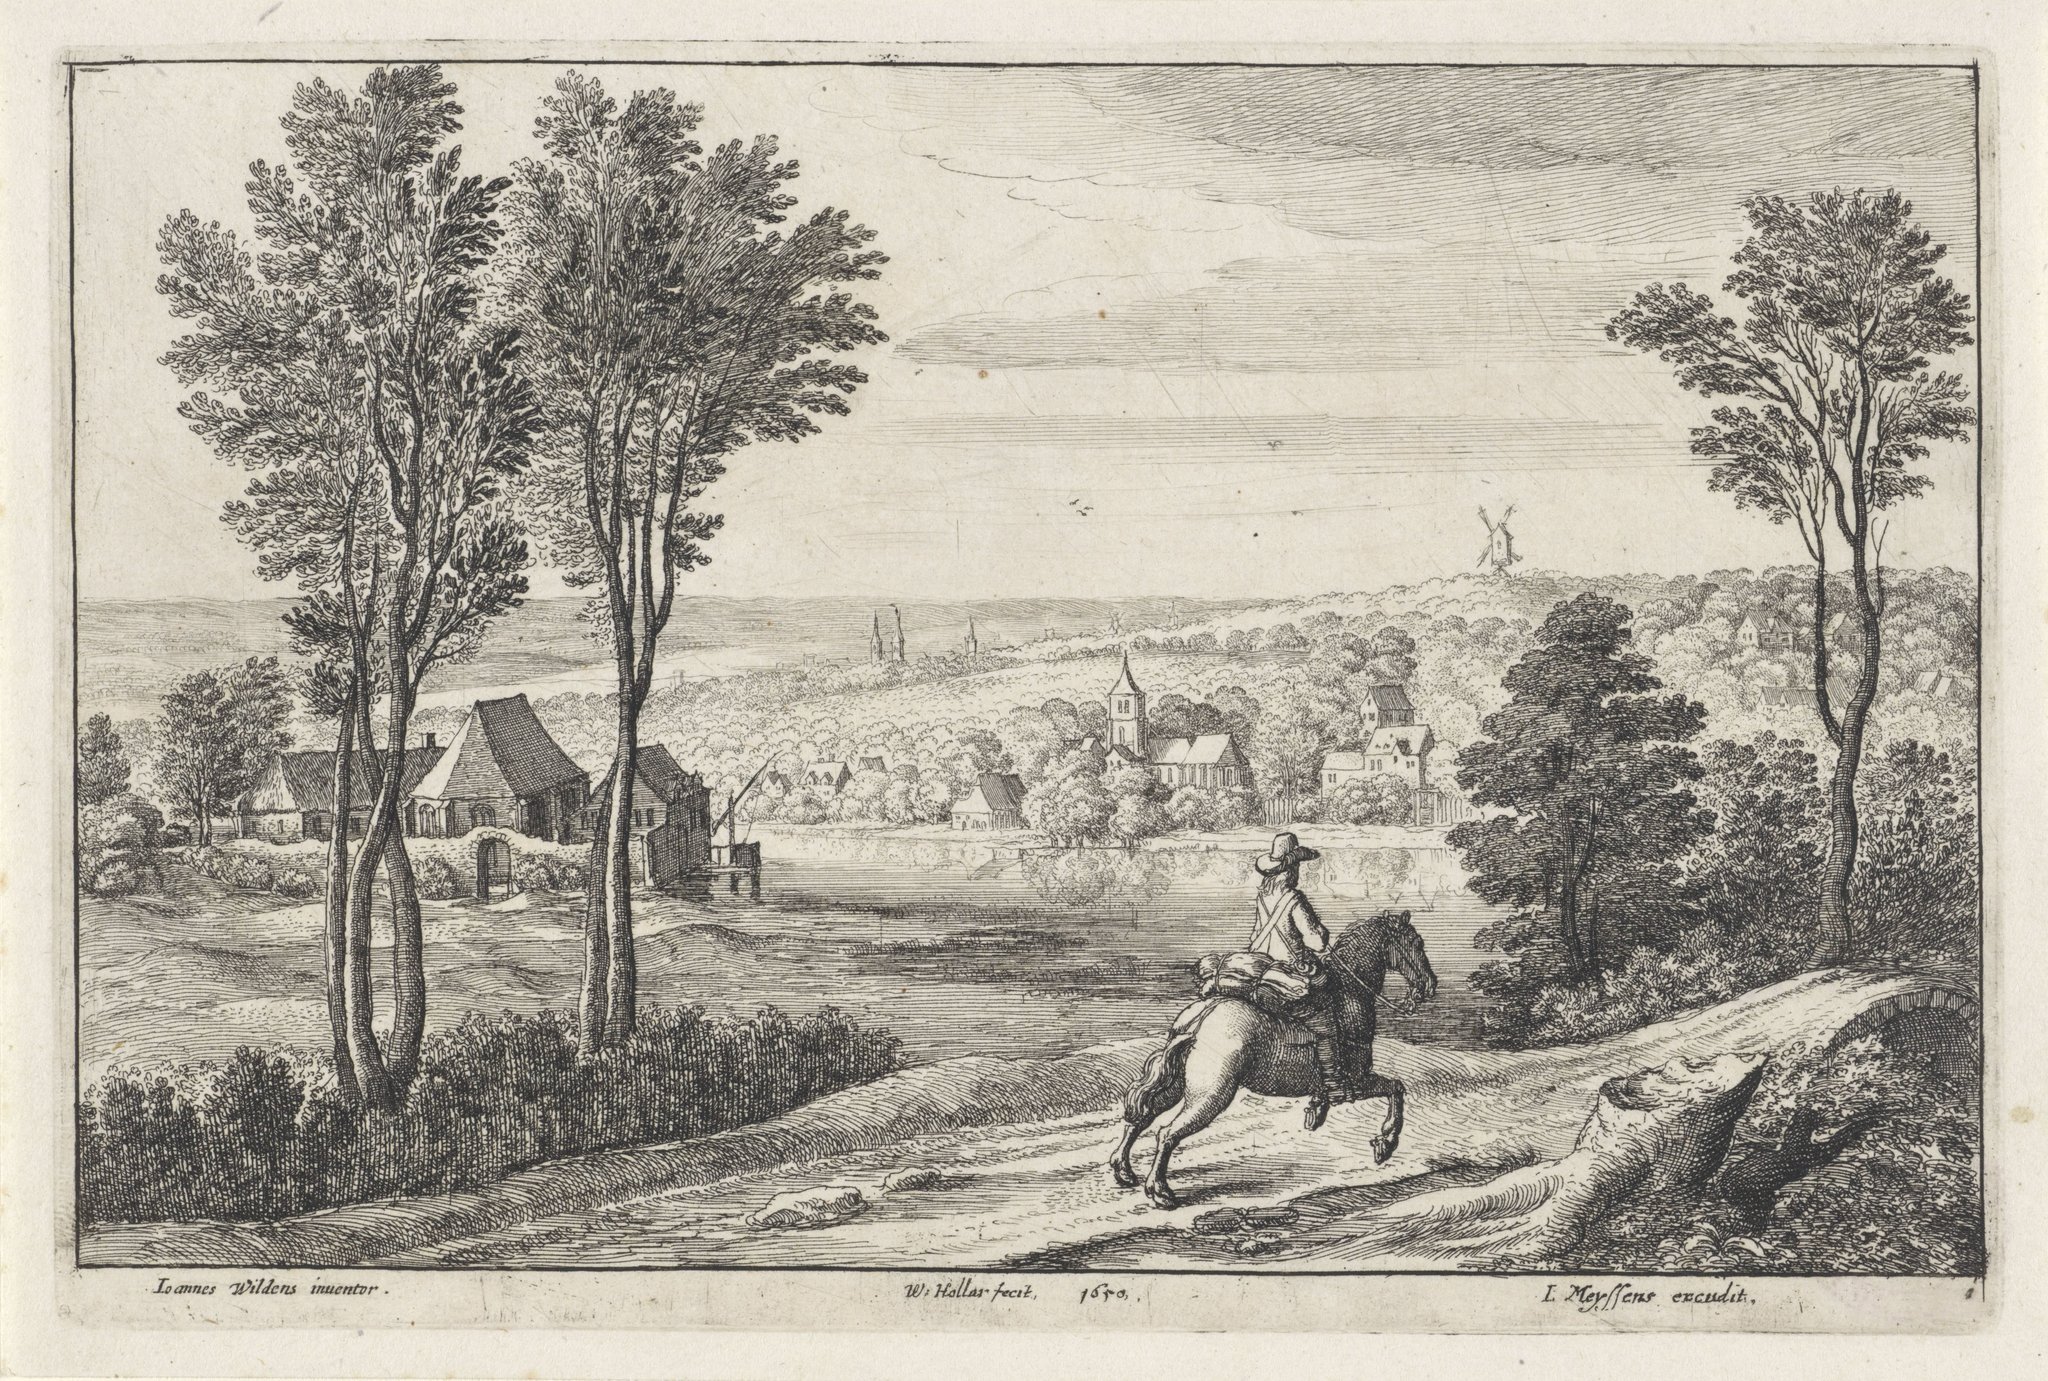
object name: print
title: Landschappen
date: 1650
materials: paper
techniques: drypoint, etching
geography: antwerp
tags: riding a horse, ass, or mule; rider, horseman, landscapes in the temperate zone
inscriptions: collector's mark: Lugt 240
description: De prent maakt deel uit van een zesdelige serie met landschappen (ongenummerd).